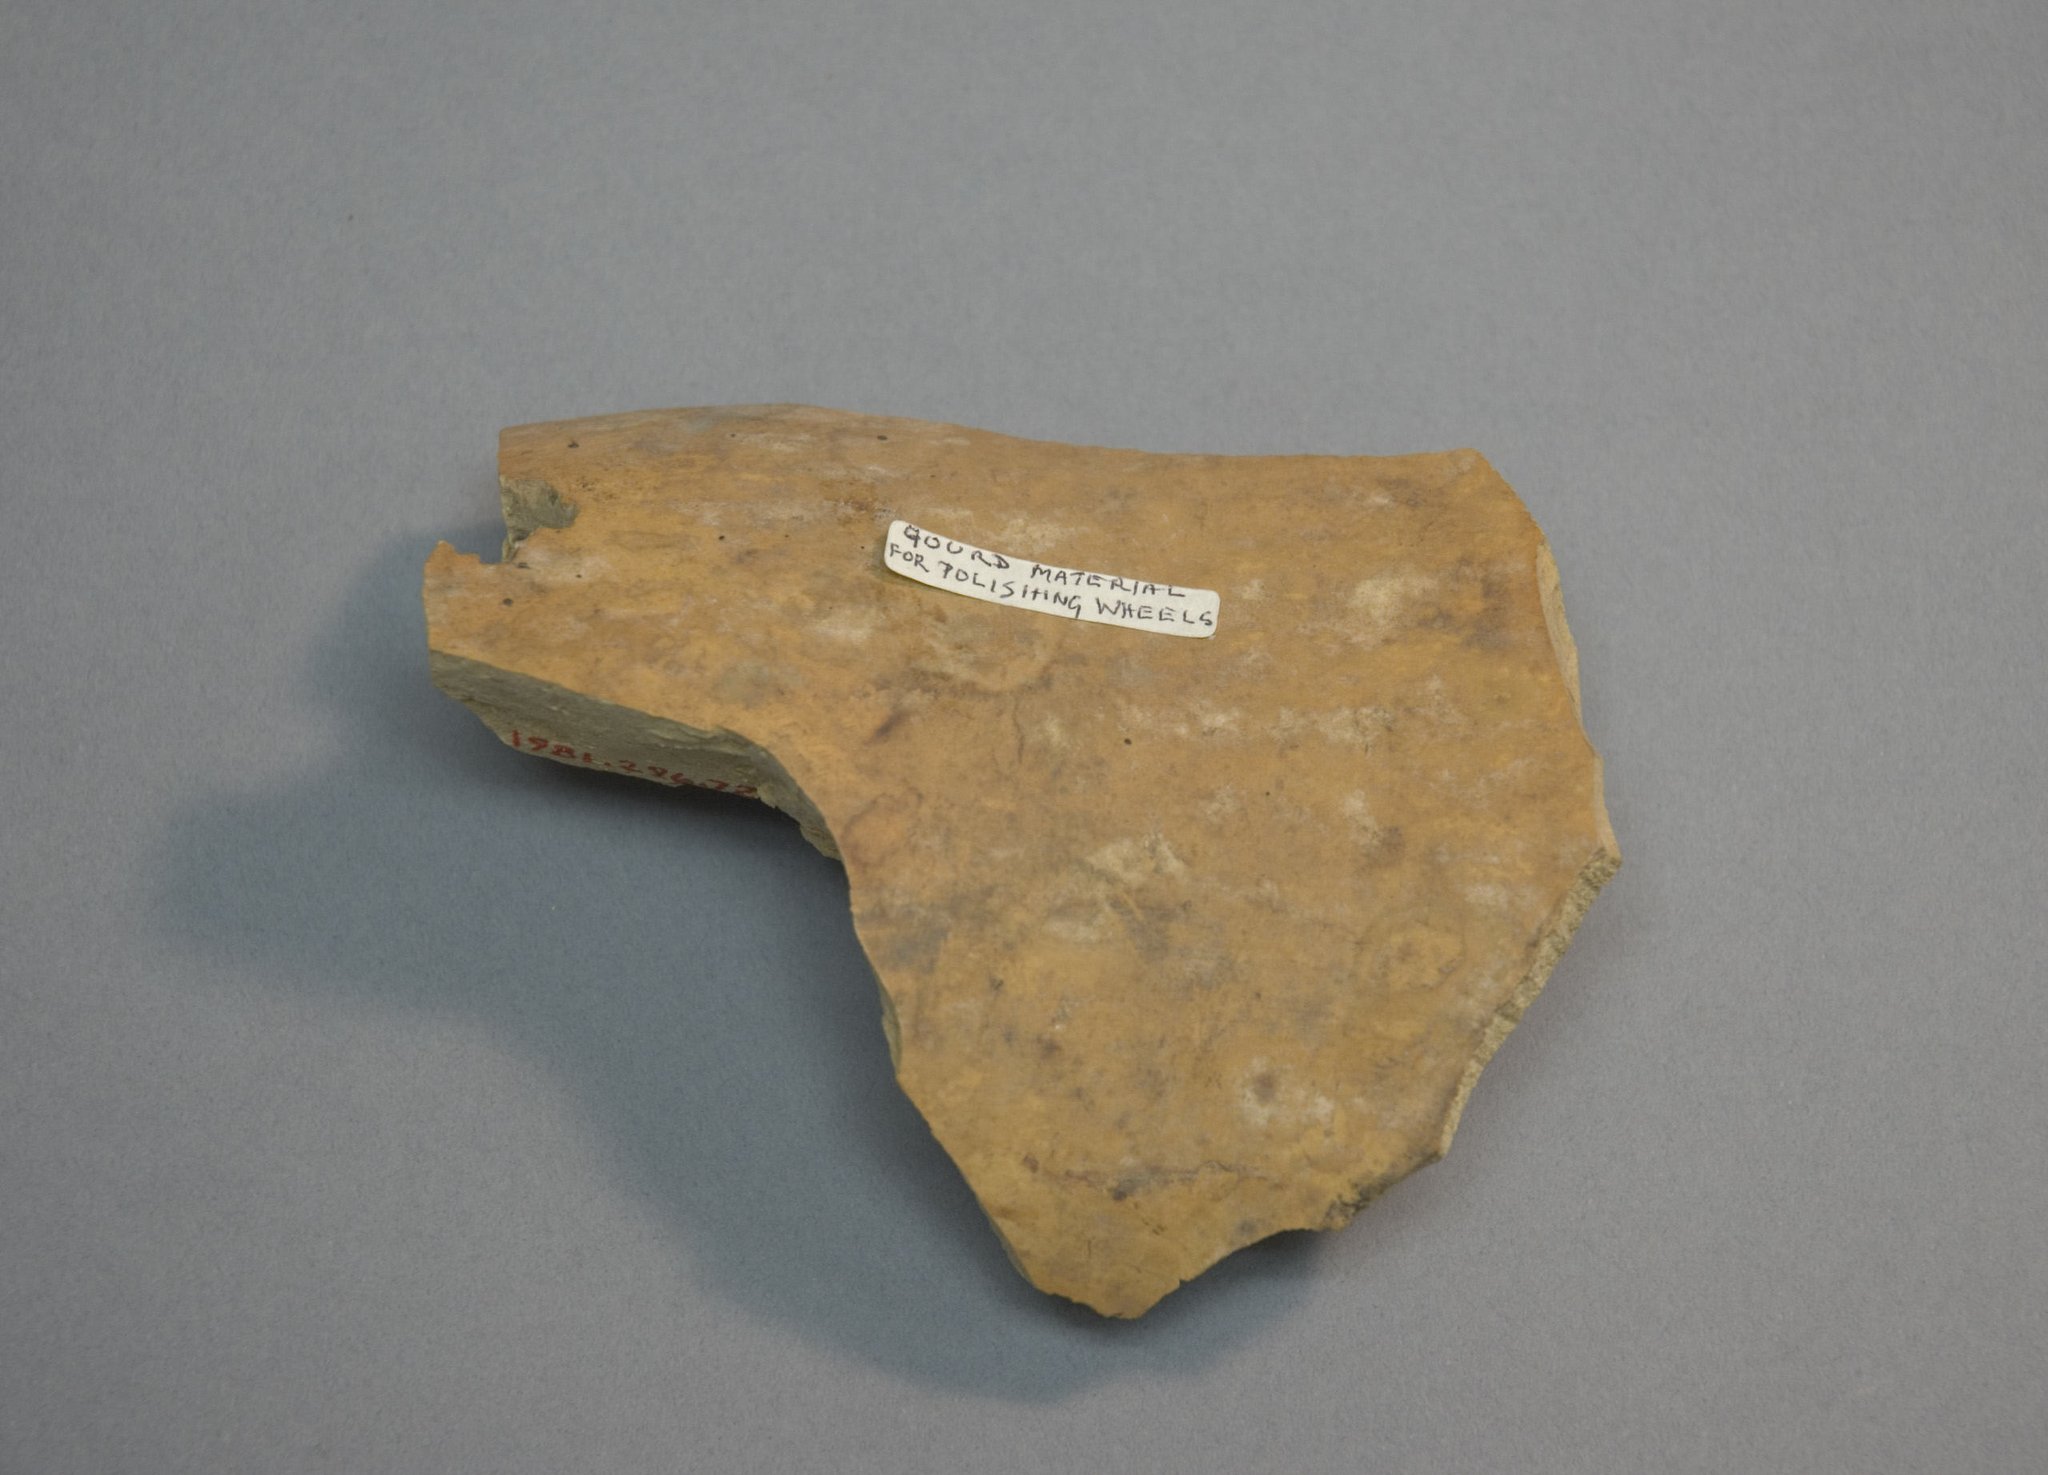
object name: jade carving material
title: Piece of Gourd Material for Polishing Wheel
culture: chinese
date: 1901-2000